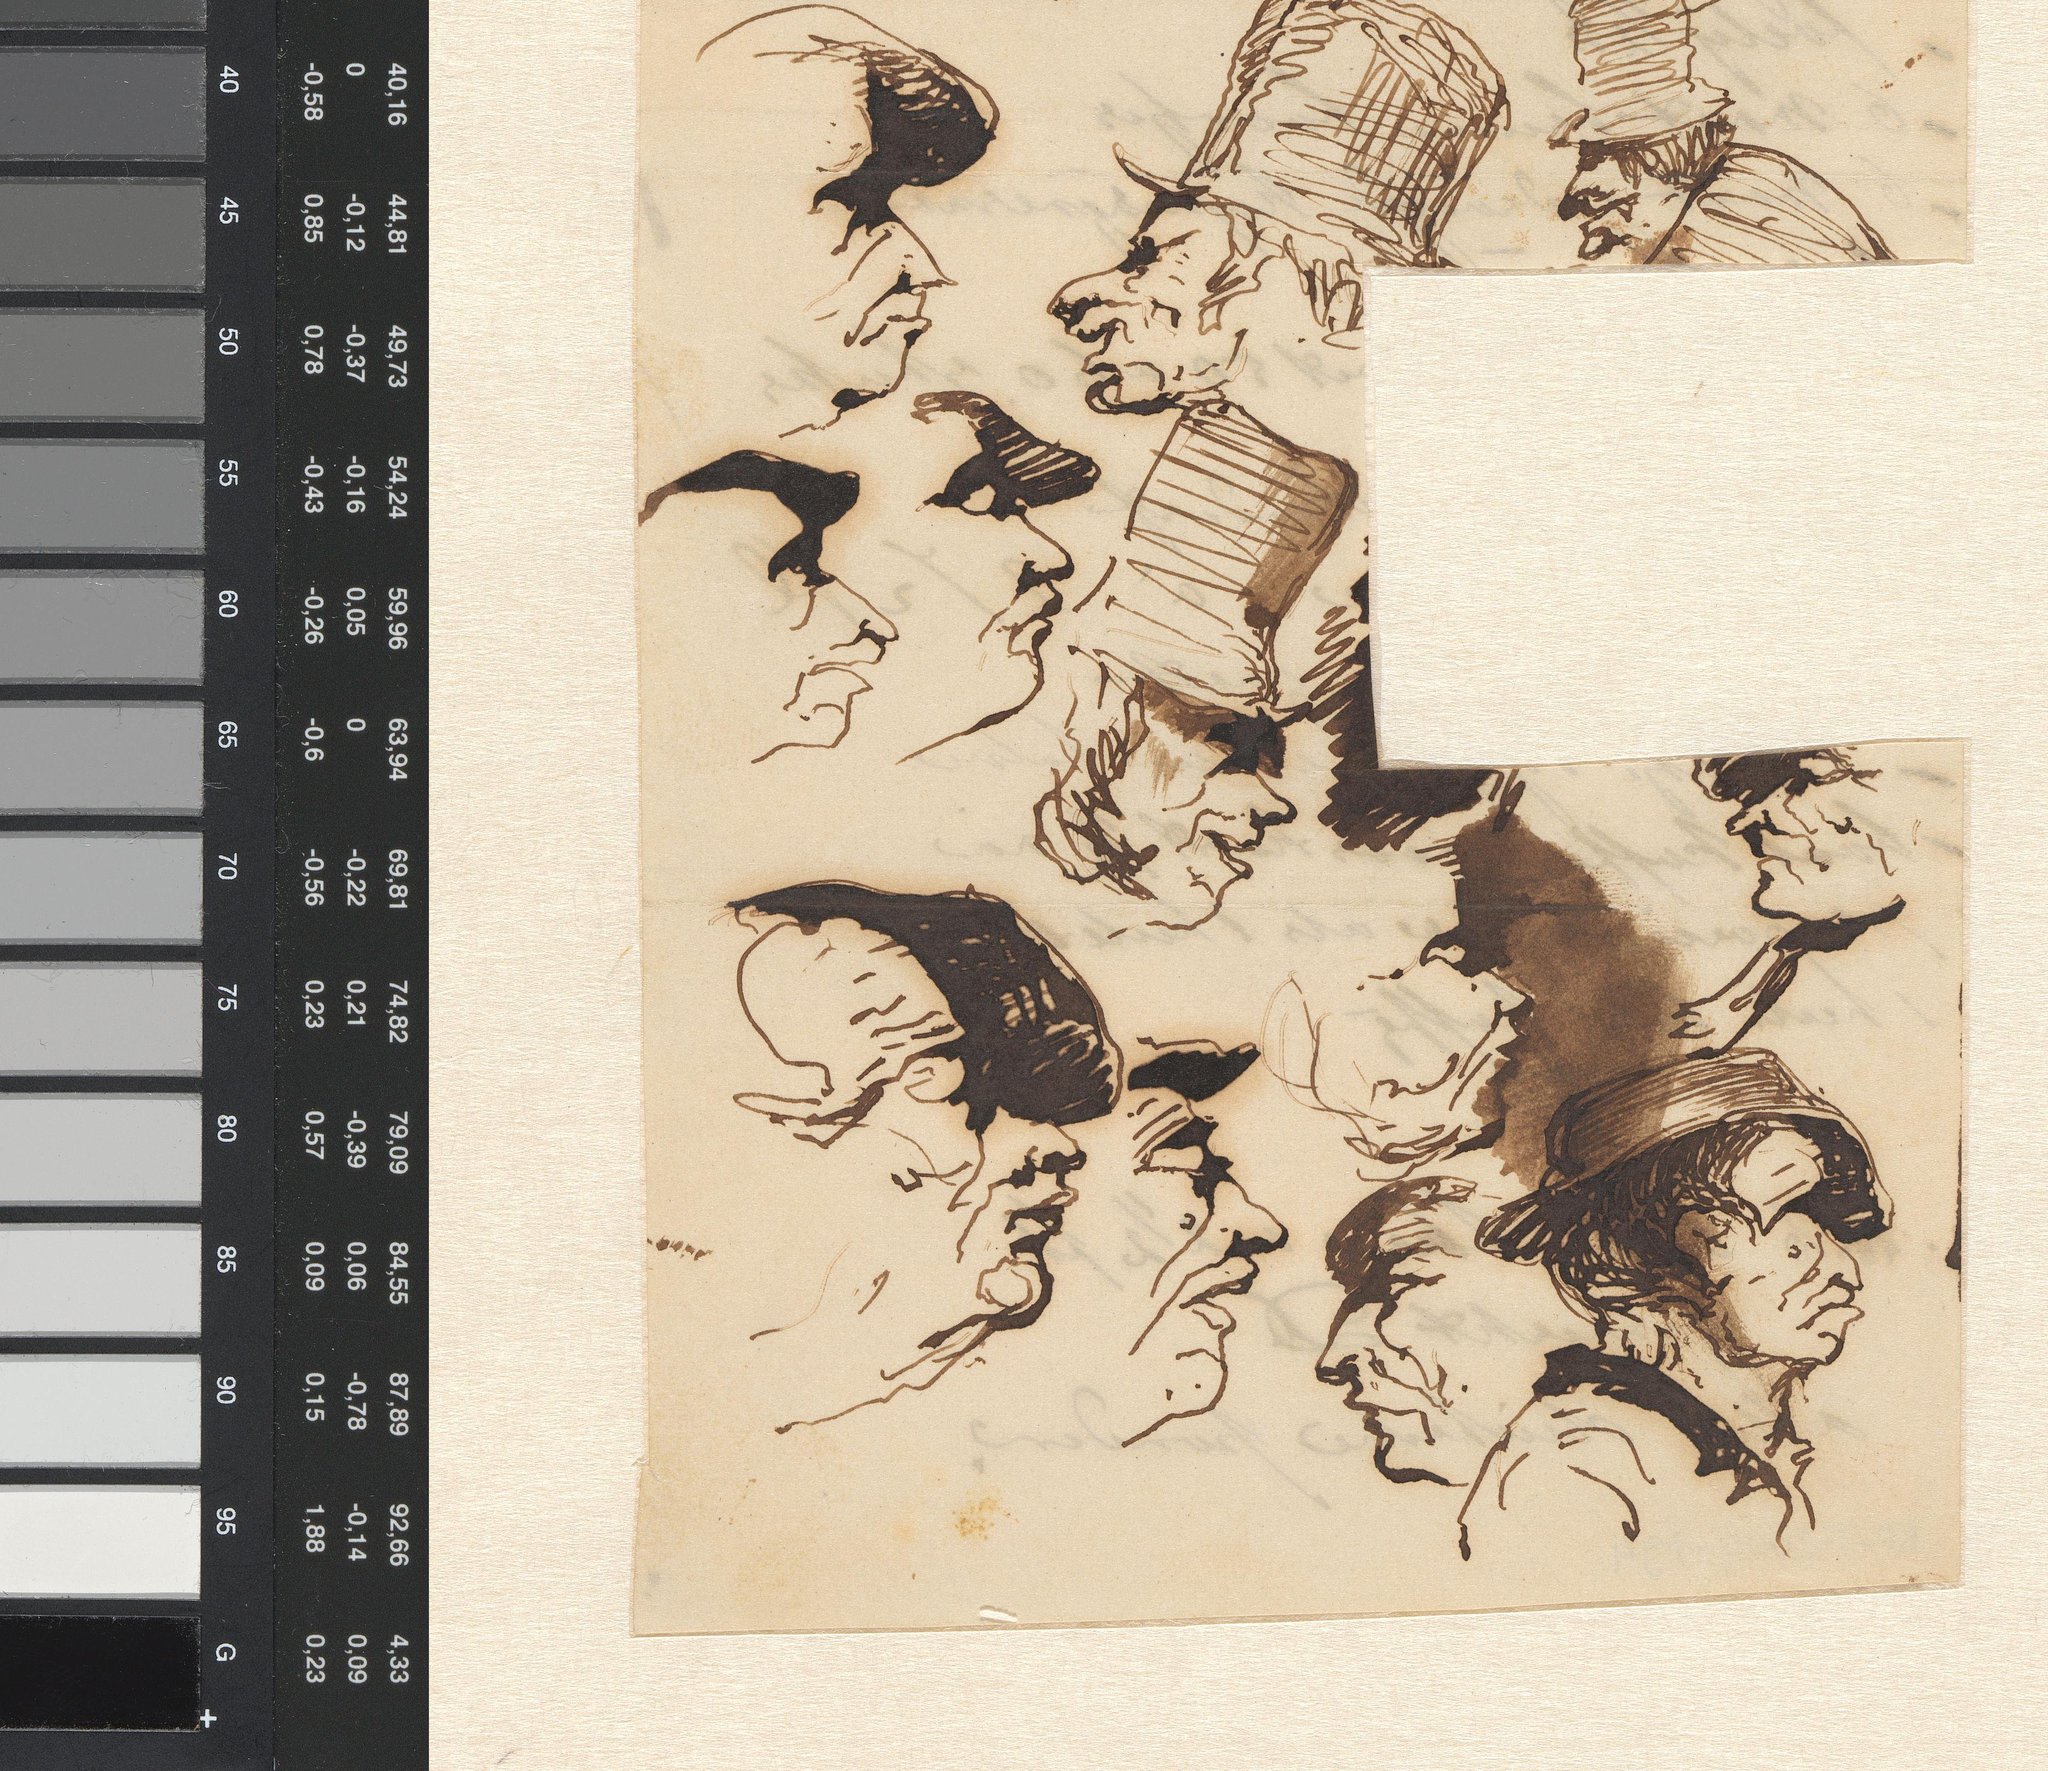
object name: drawing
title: Blad met koppen en aantekeningen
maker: johannes tavenraat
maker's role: draughtsman, painter, print maker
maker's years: 1809-1881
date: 1840-1880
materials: ink, paper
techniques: pen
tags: caricatures (human types)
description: Blad met koppen en aantekeningen, meer aantekeningen op de verso-zijde